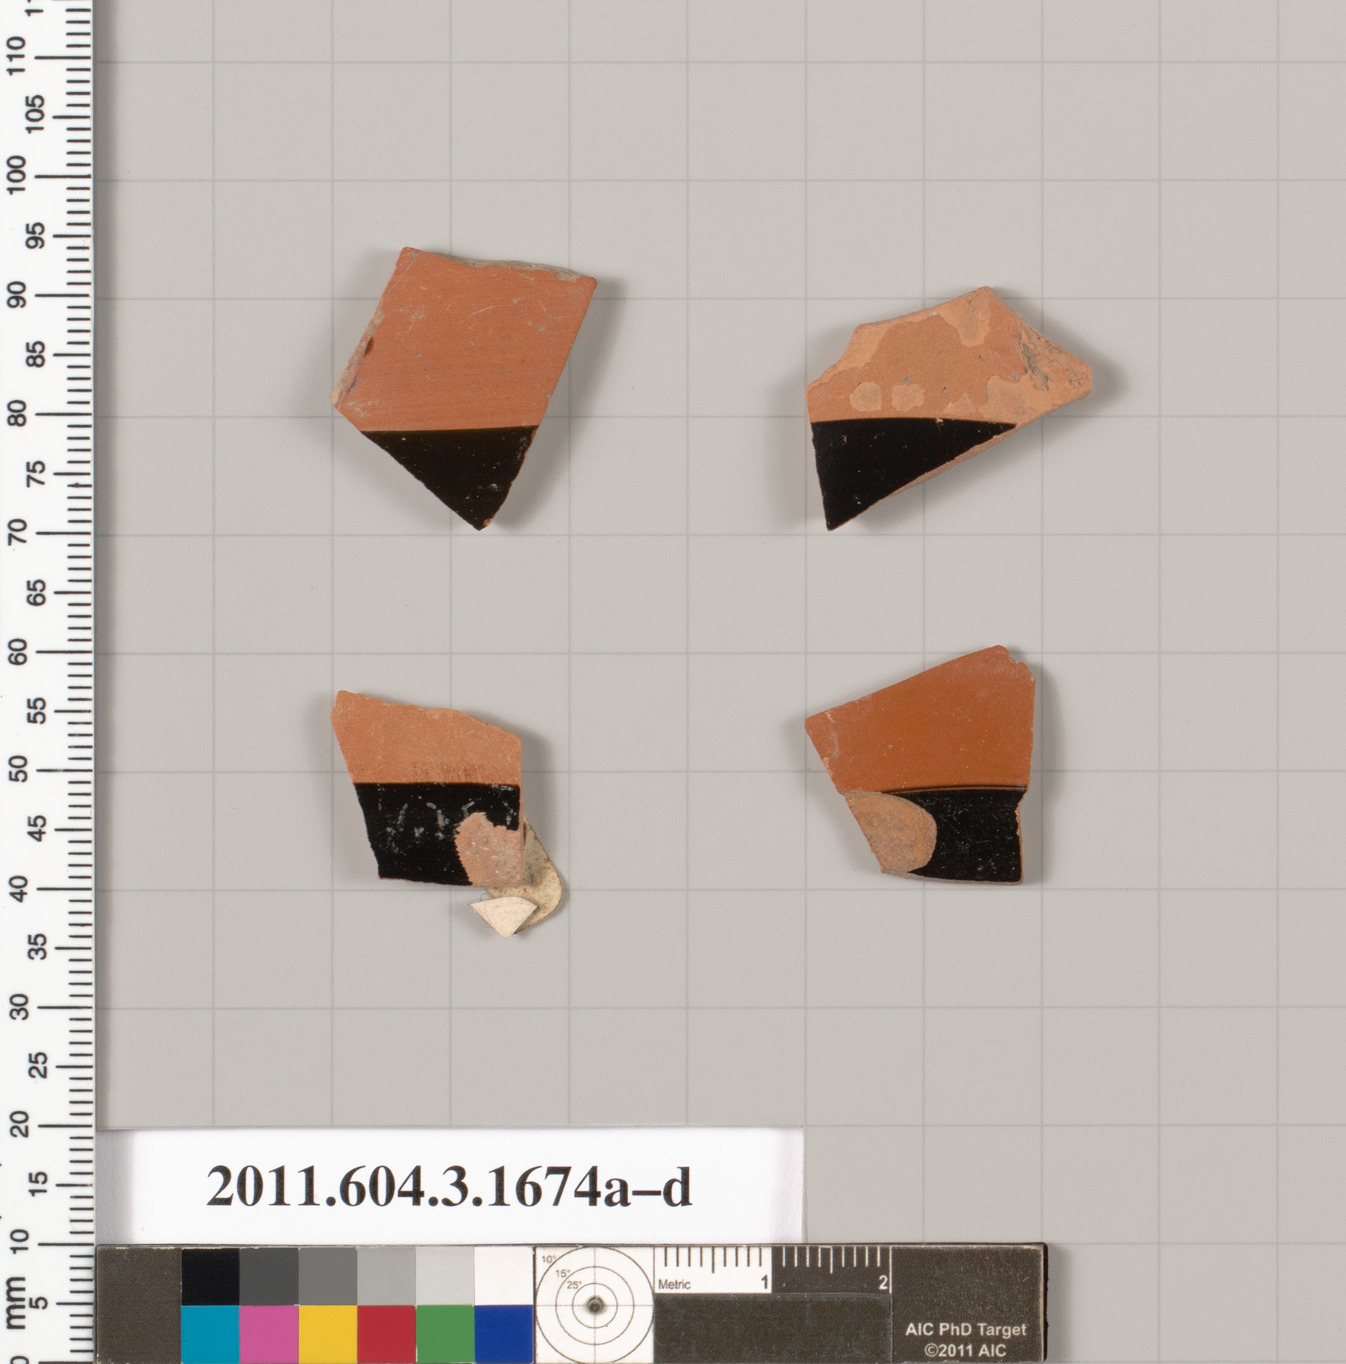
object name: kylix fragment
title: Terracotta fragments of kylikes: Band or lip cups (drinking cups)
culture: greek, attic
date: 550-526 BCE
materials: terracotta